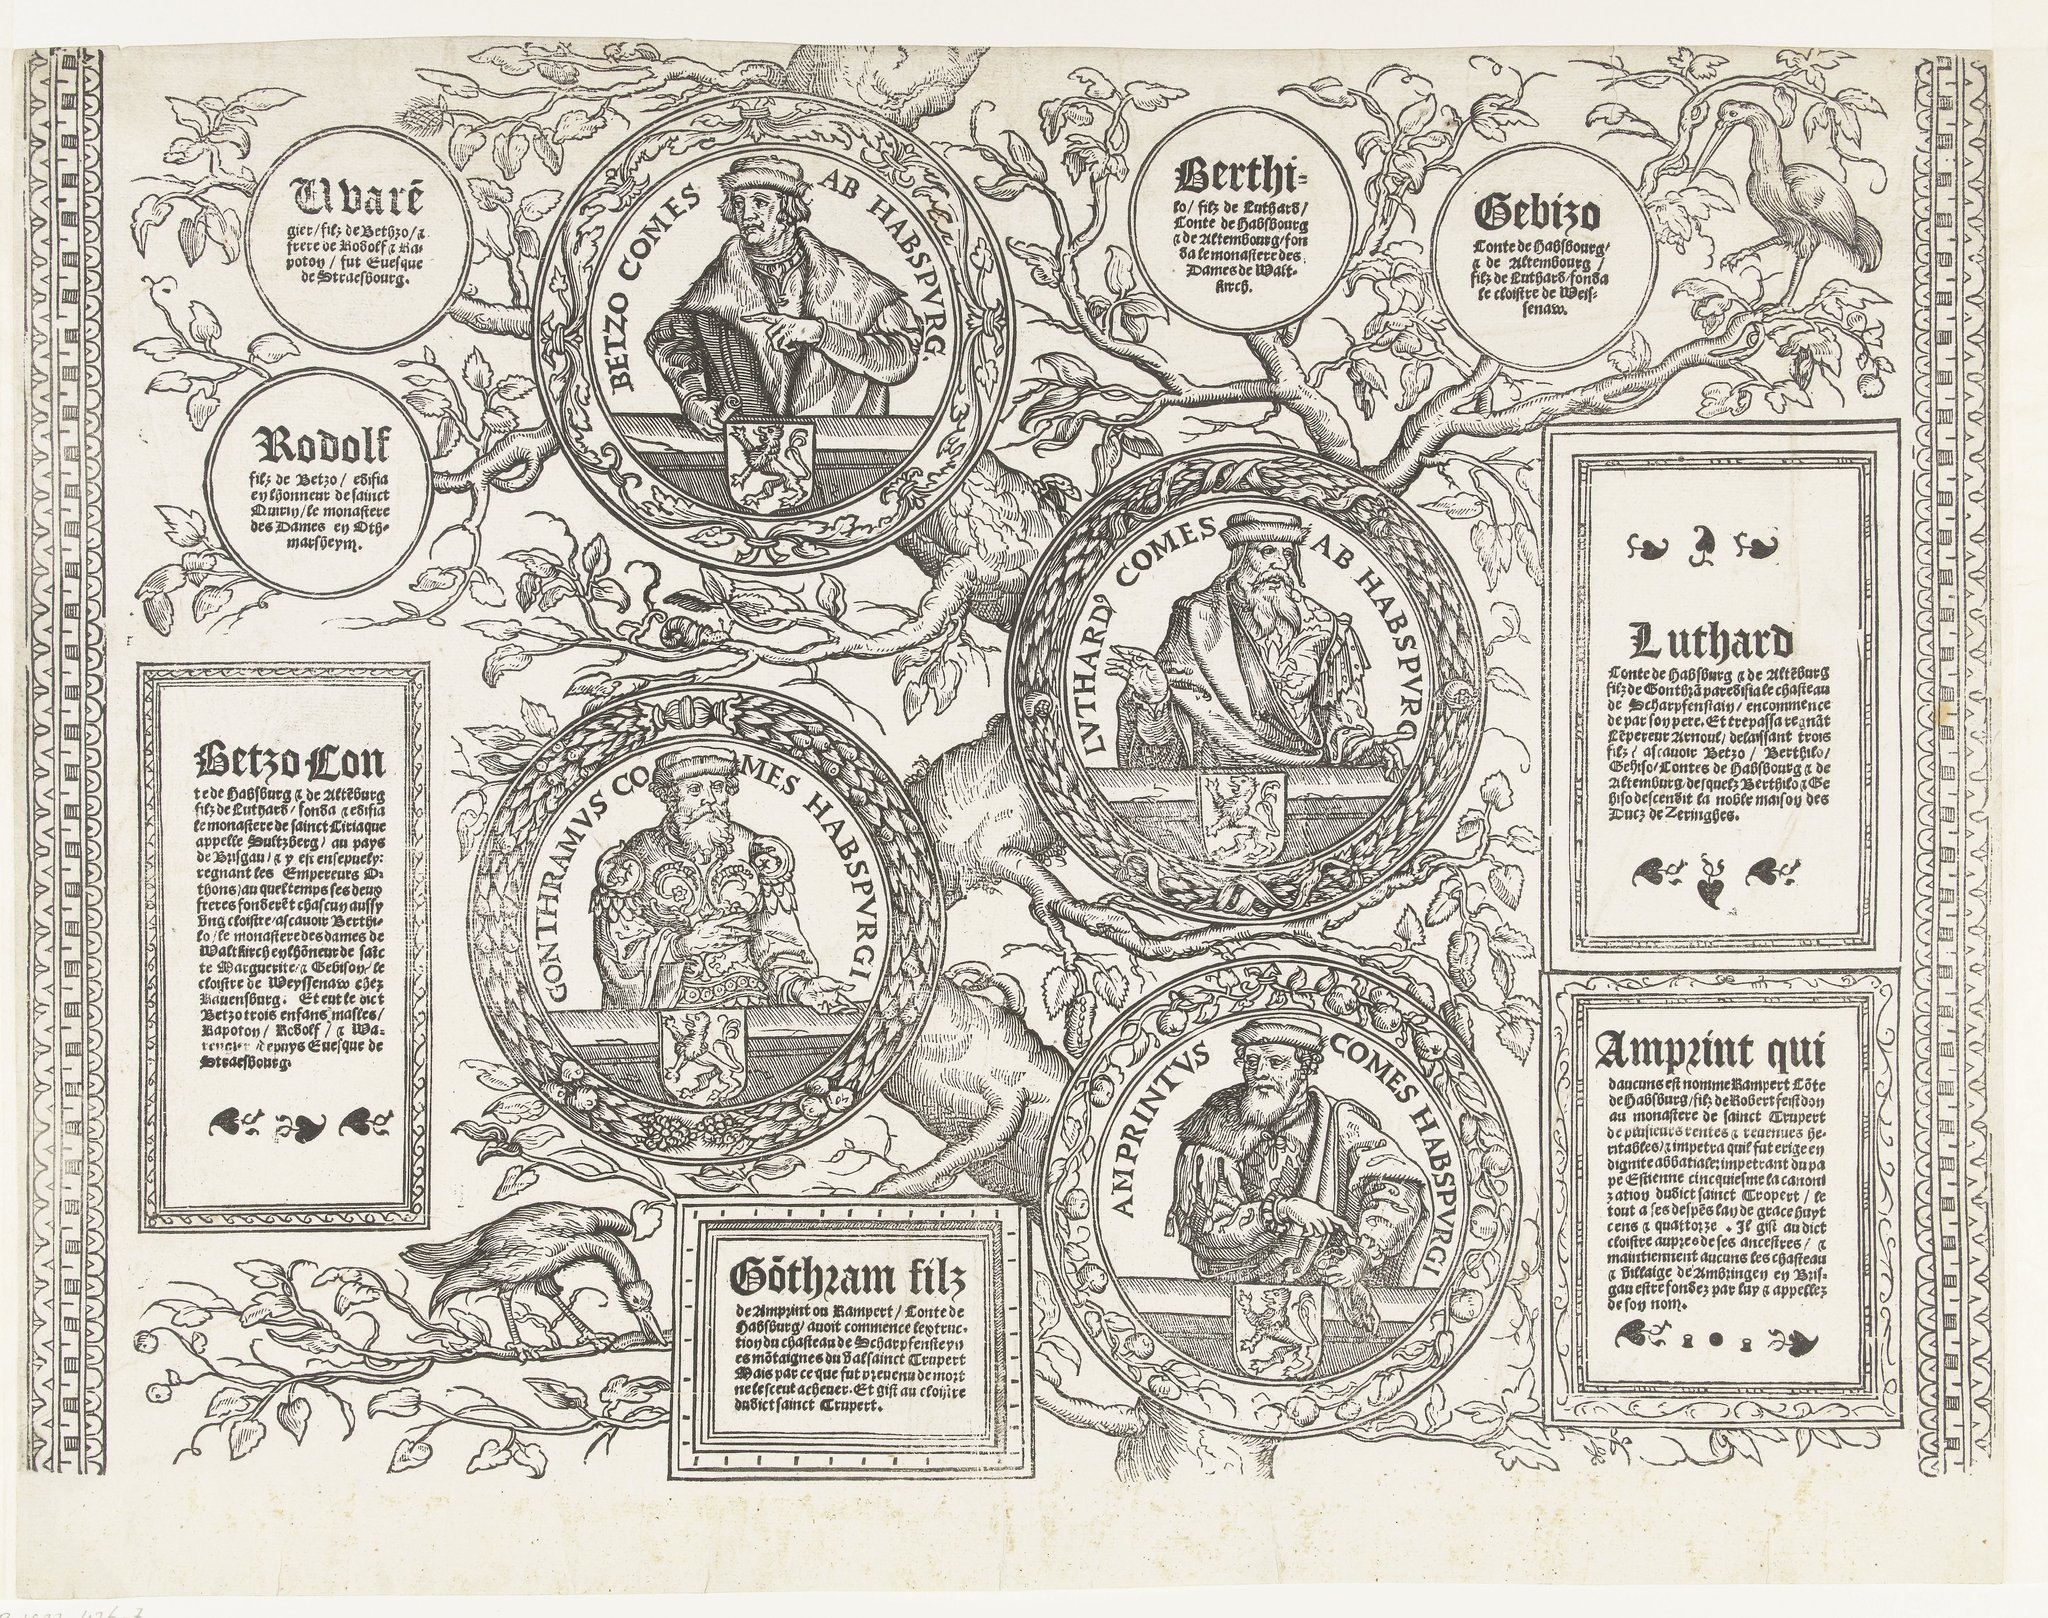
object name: print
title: Stamboom van het Habsburgse Huis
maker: robert péril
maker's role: draughtsman, print maker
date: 1533-1535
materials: paper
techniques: woodcut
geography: antwerp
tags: family lineage, pedigree, genealogical tree or table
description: Eén blad van twintig, vormen samen een stamboom. In de boom vier medaillons met de graven van Habsburg: Amprintus, Contramus, Luthardus en Bezo. Vier cartouches met tekst over hen in het Frans. Vier kleine medaillons met de namen van familieleden.